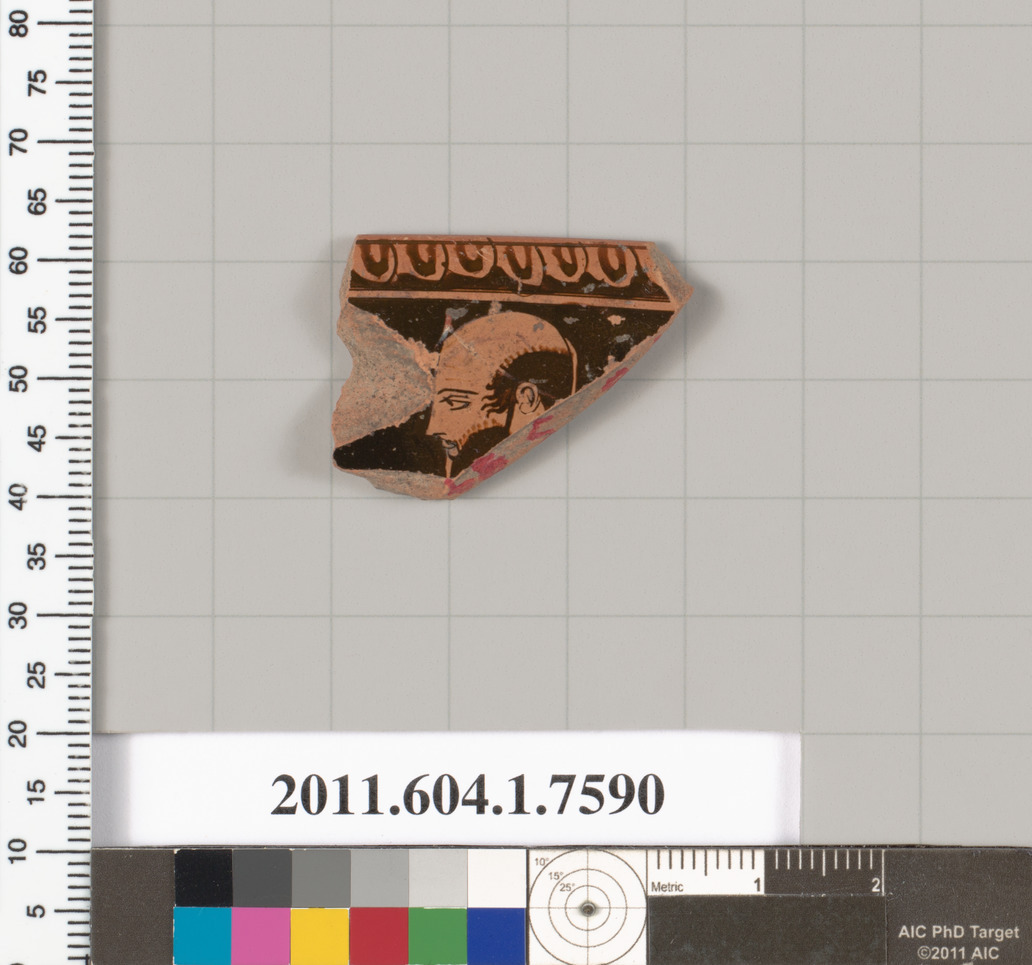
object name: kylix fragment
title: Terracotta rim fragment of a kylix (drinking cup)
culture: greek, attic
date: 460-450 BCE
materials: terracotta